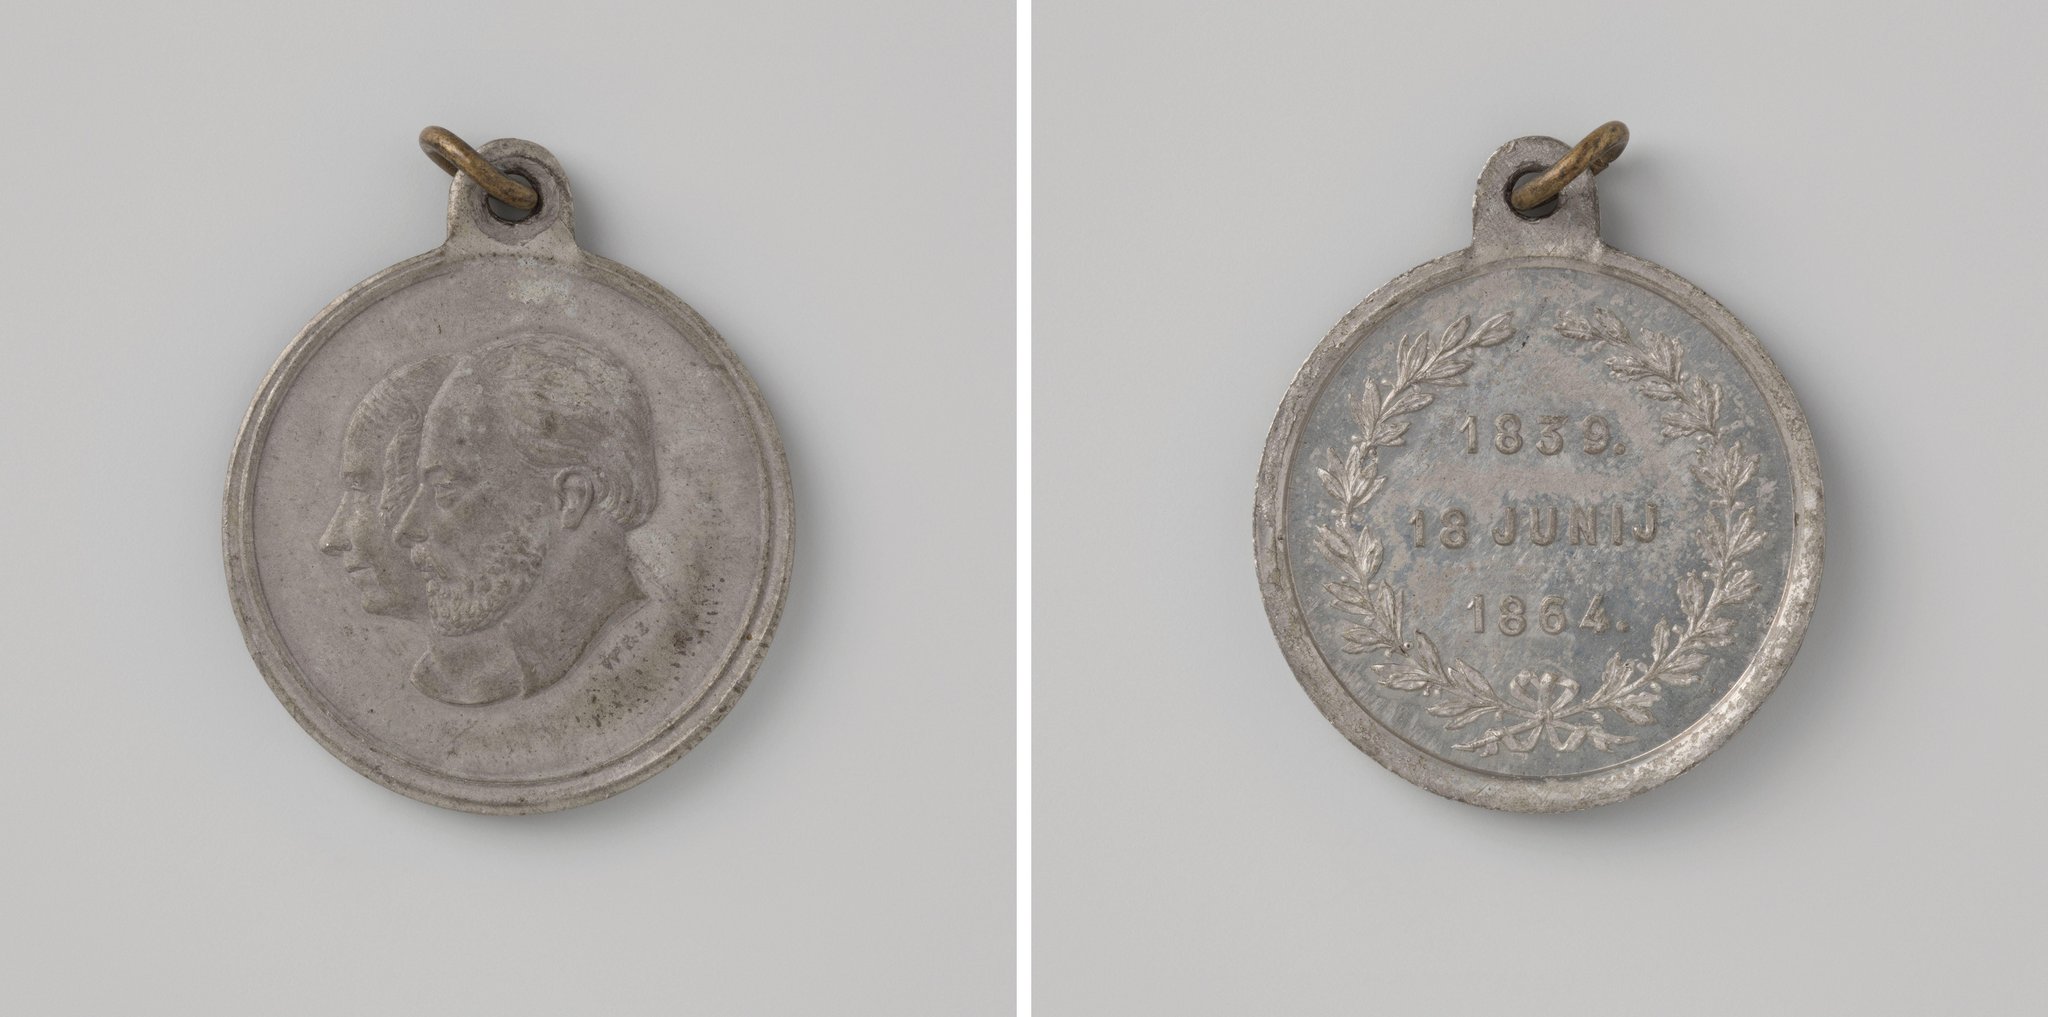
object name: history medal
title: Vijfentwintigjarig huwelijk van Koning Willem III en Sophia van Wurtemberg 1864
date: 1864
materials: tin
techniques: striking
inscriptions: inscription: ‘1839. / 18 JUNIJ / 1864.’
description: Tinnen penning met oog en draagring, op de voorzijde de geconjugeerde portretten van Sophia en Willem naar links, op de keerzijde drie regels tekst tussen samengestrikte lauwer- en eikentakken.